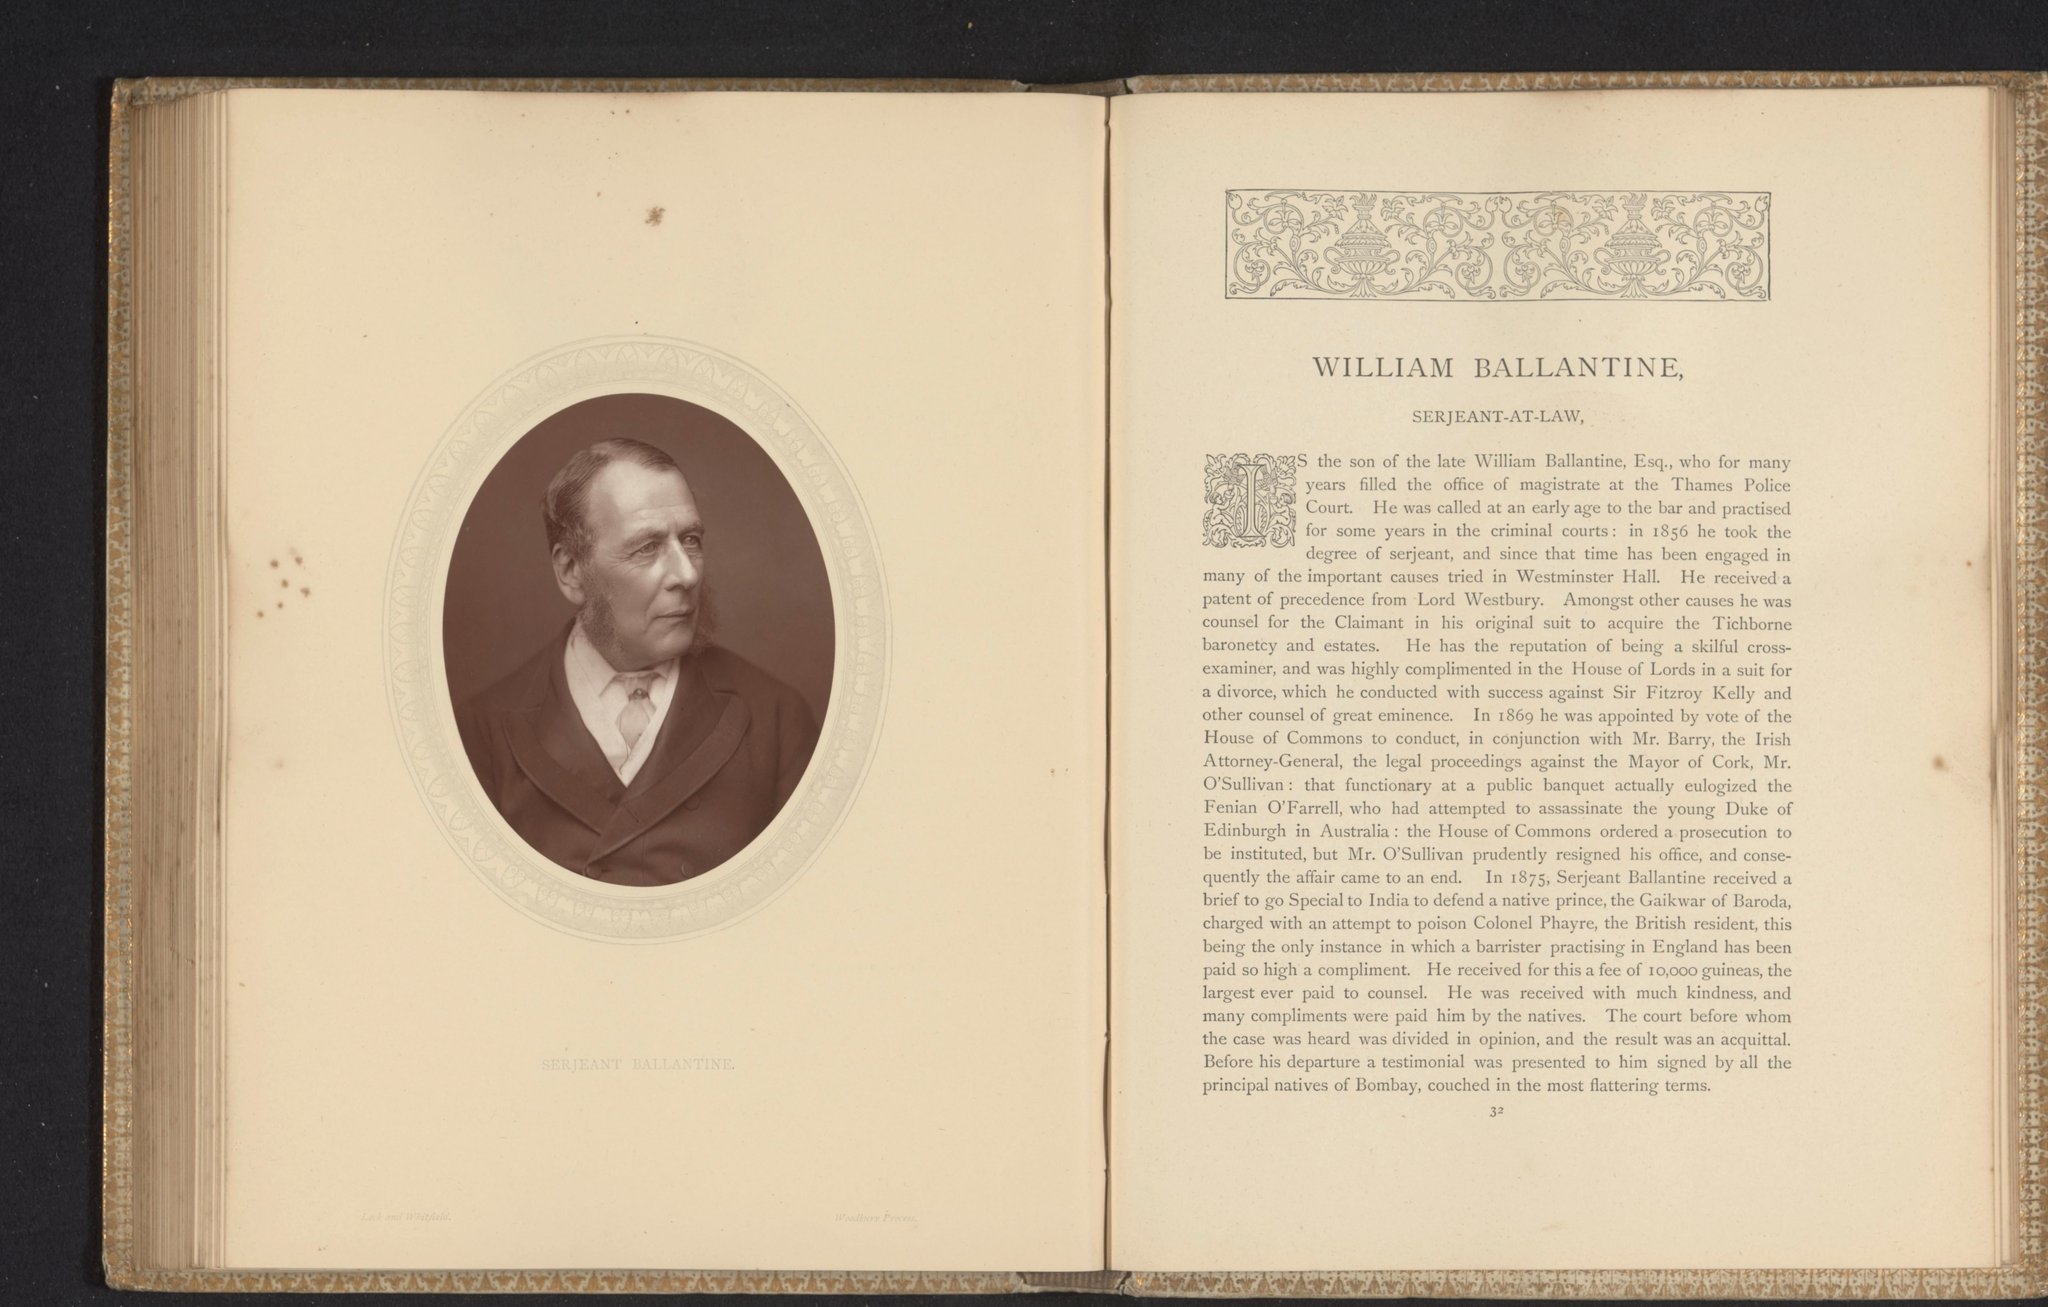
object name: page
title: Serjeant Ballantine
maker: Anonymous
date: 1877-1882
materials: paper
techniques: woodburytype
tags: lawyer, attorney at law, historical persons (portraits and scenes from the life) (+ (full) bust portrait)